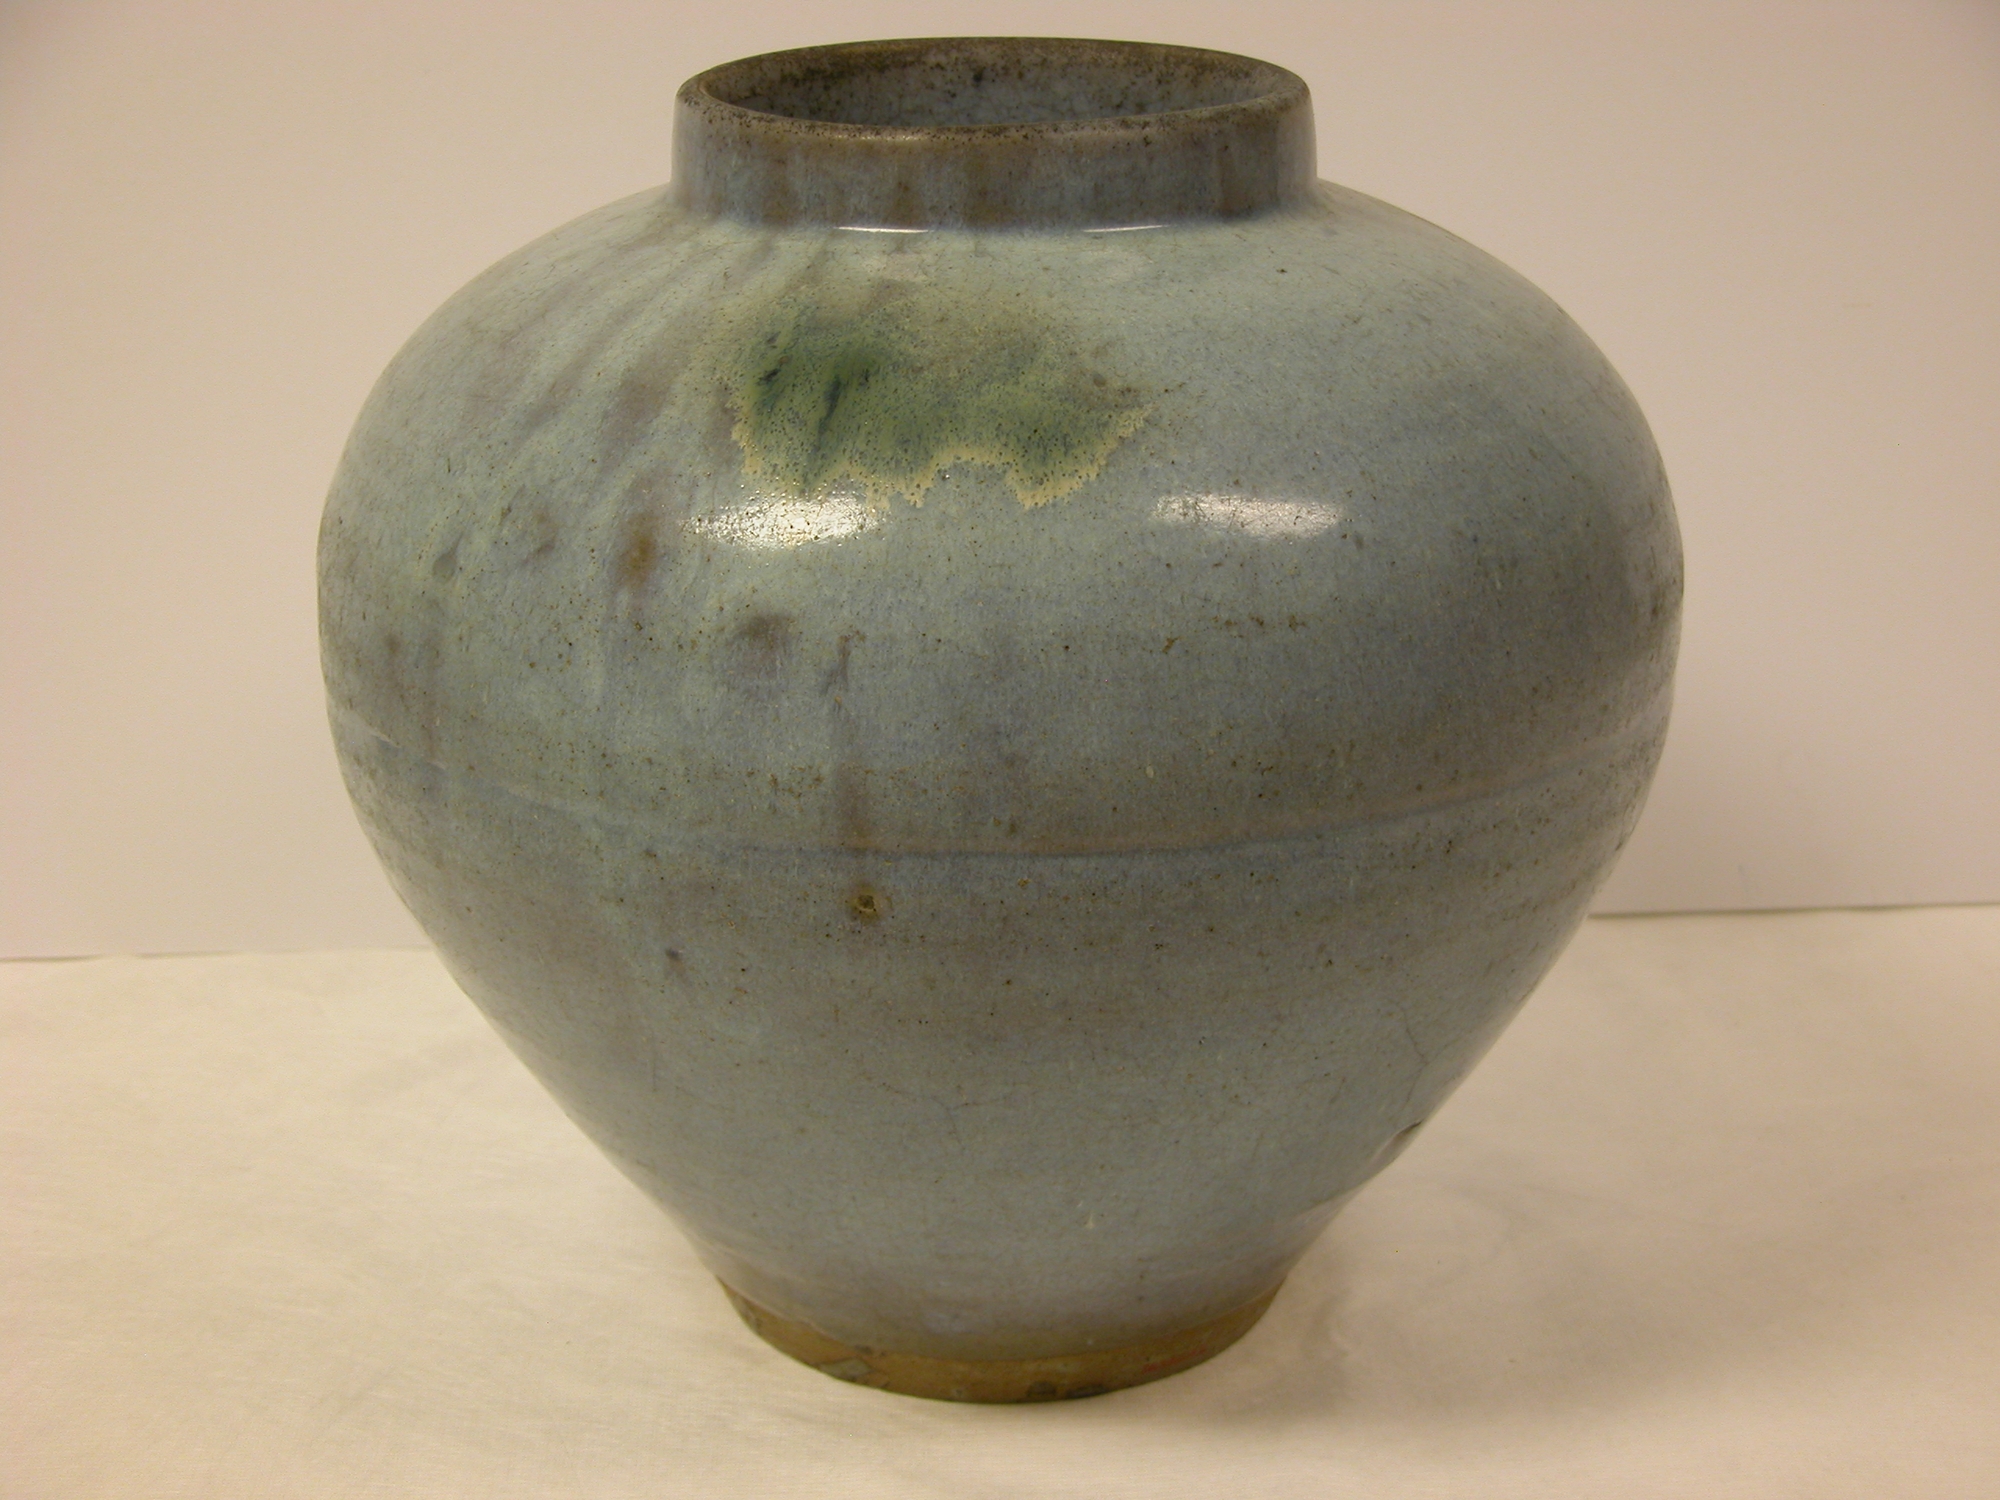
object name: jar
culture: chinese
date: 1279-1368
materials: pottery